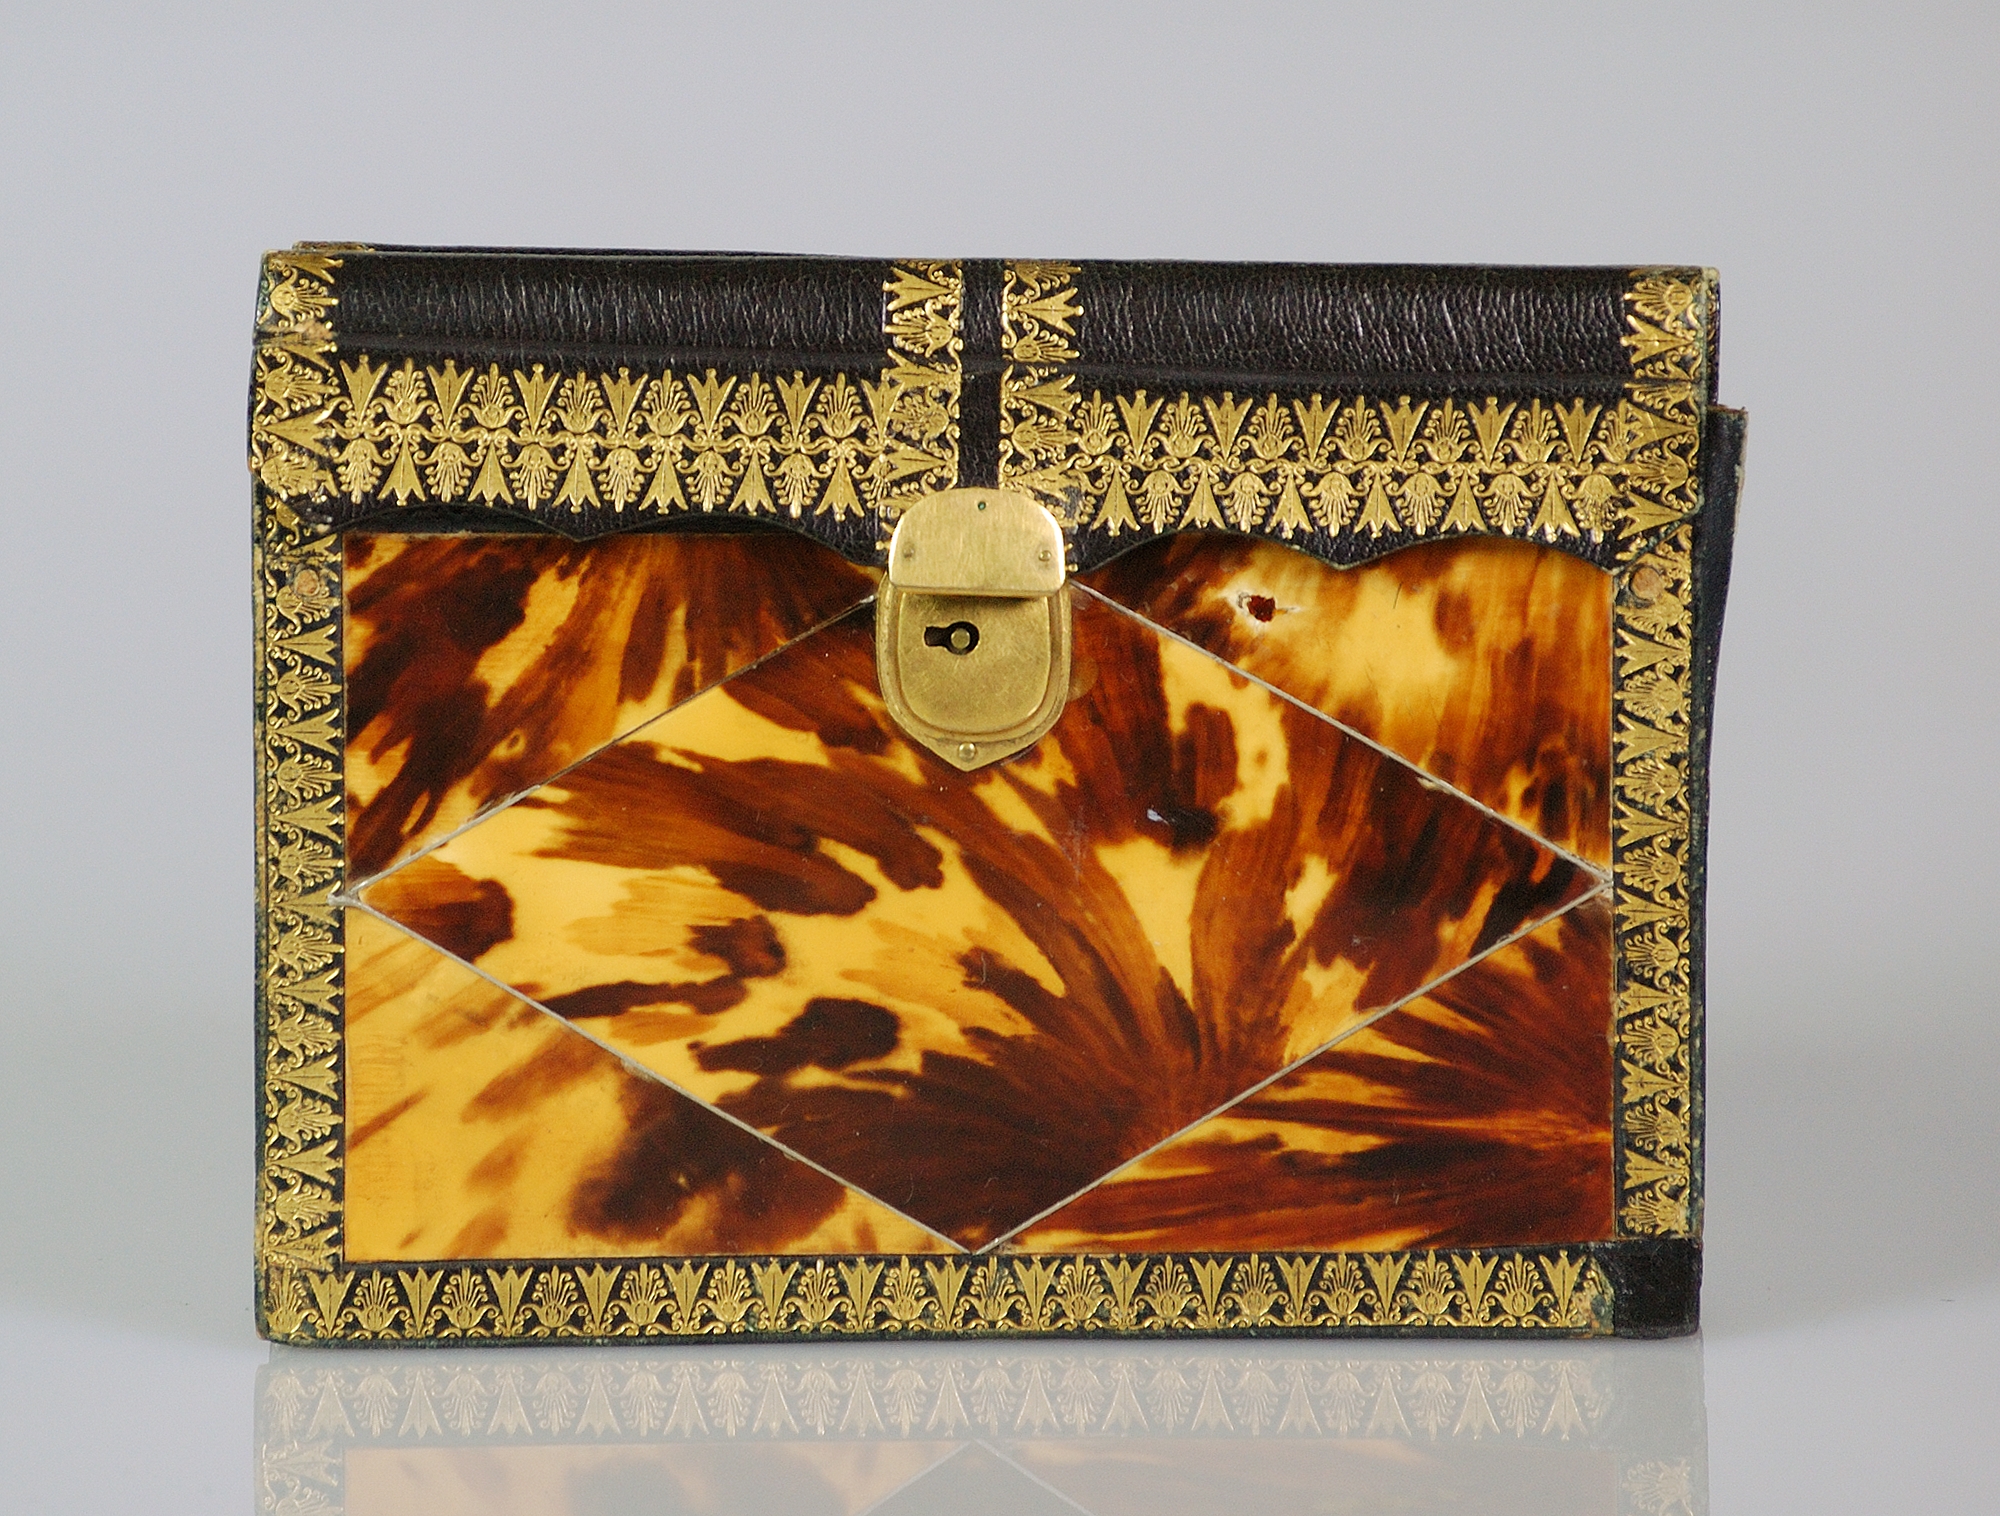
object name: clutch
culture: american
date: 1851-1875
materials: leather, metal, plastic, silk